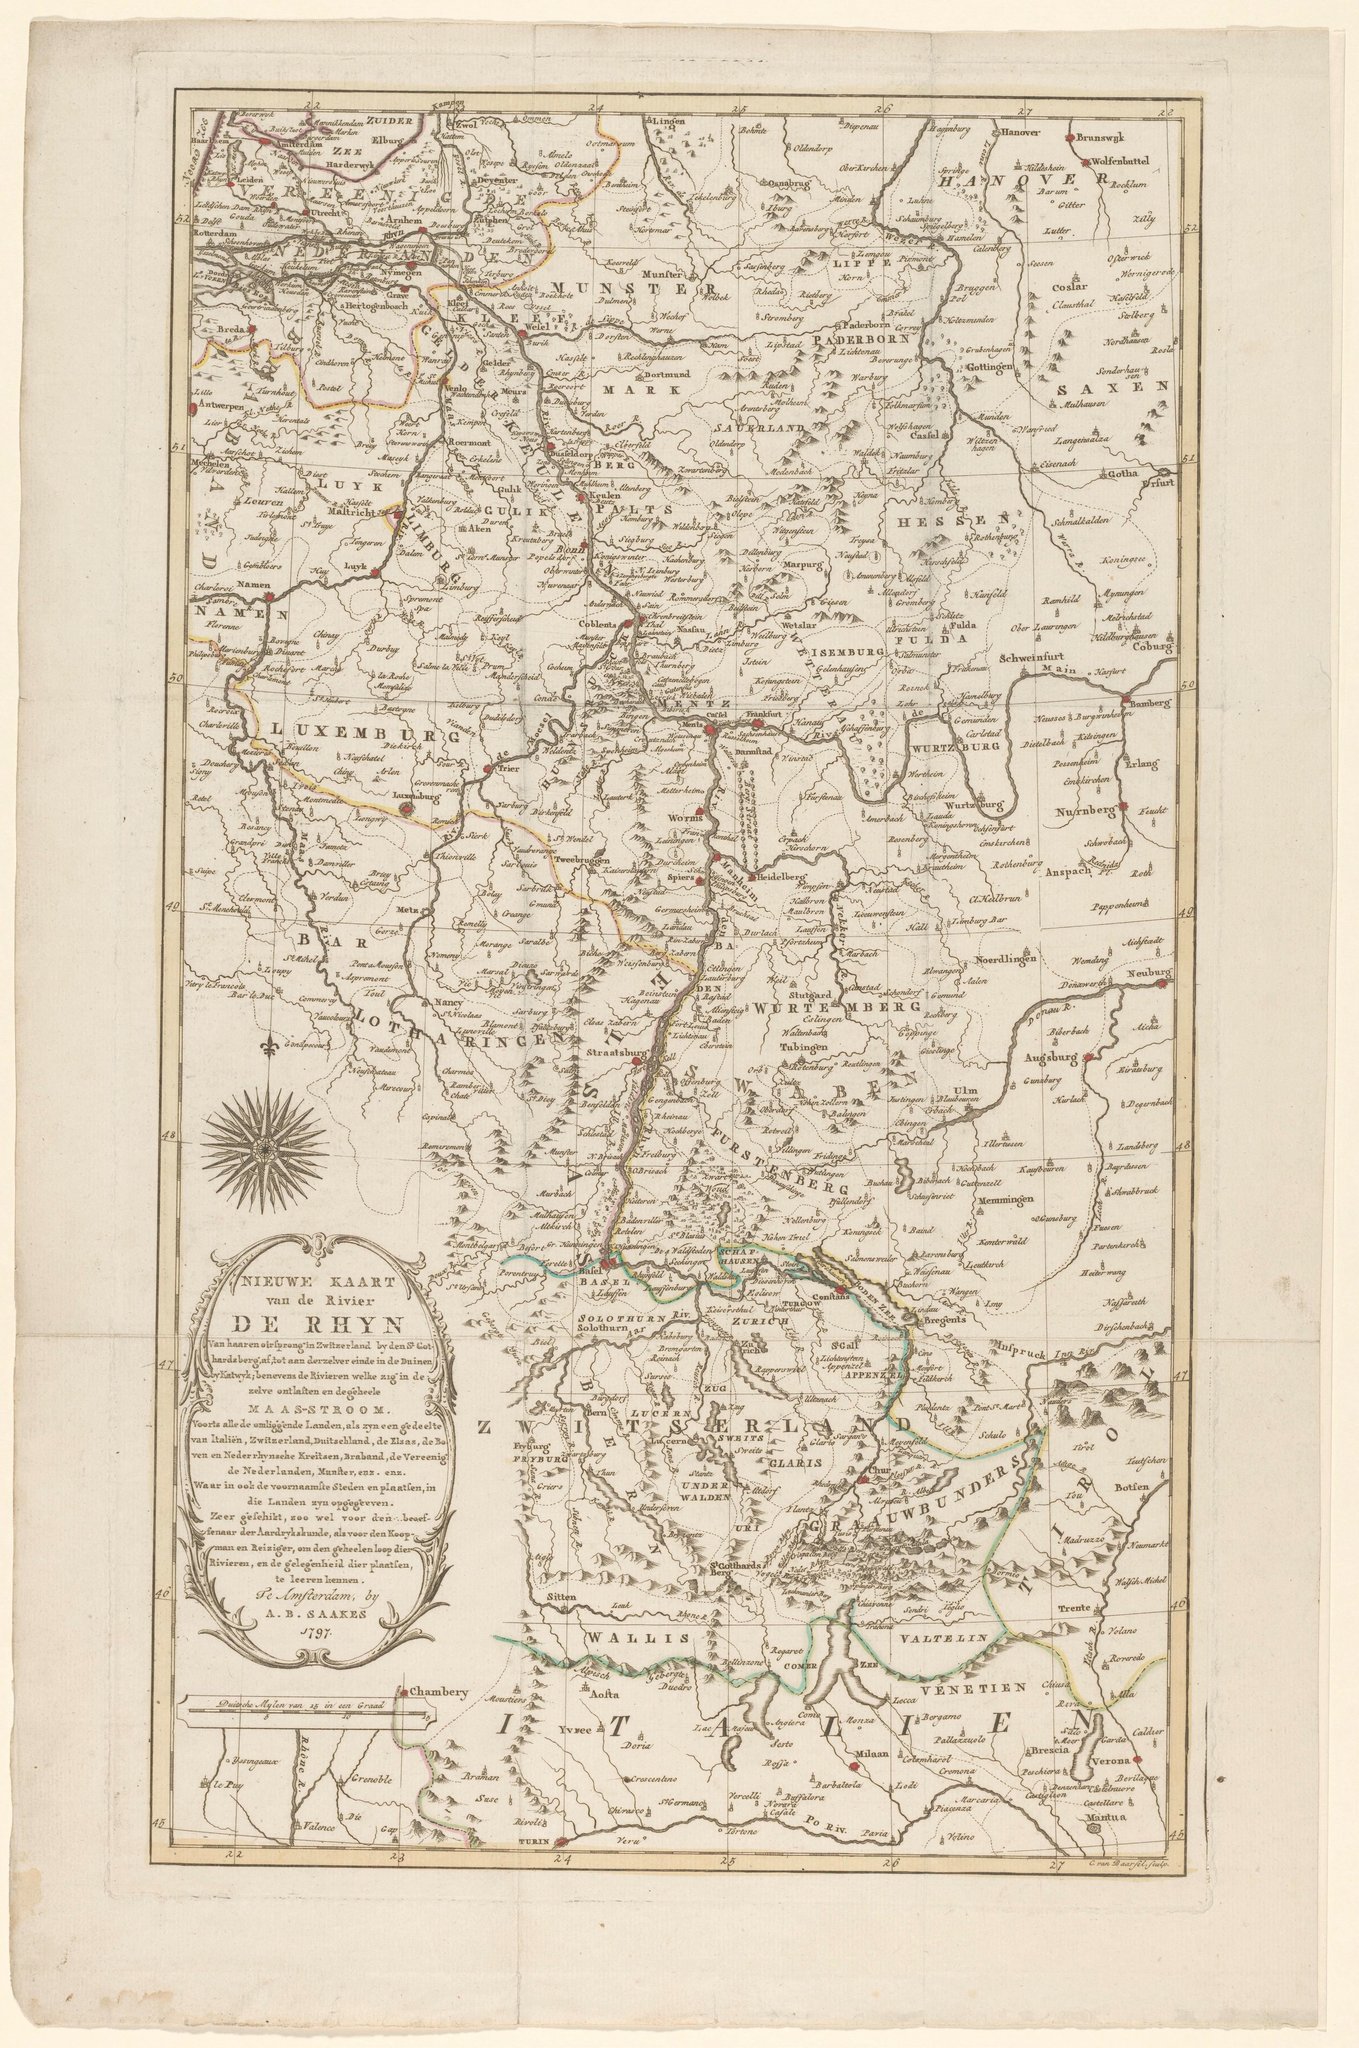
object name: print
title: Kaart van het stroomgebied van de Rijn van Zwitserland naar Holland, 1797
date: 1797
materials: paper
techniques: engraving, etching, hand coloring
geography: amsterdam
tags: maps of separate countries or regions, river, germany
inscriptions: collector's mark: Lugt 2760, collector's mark: Lugt 2166